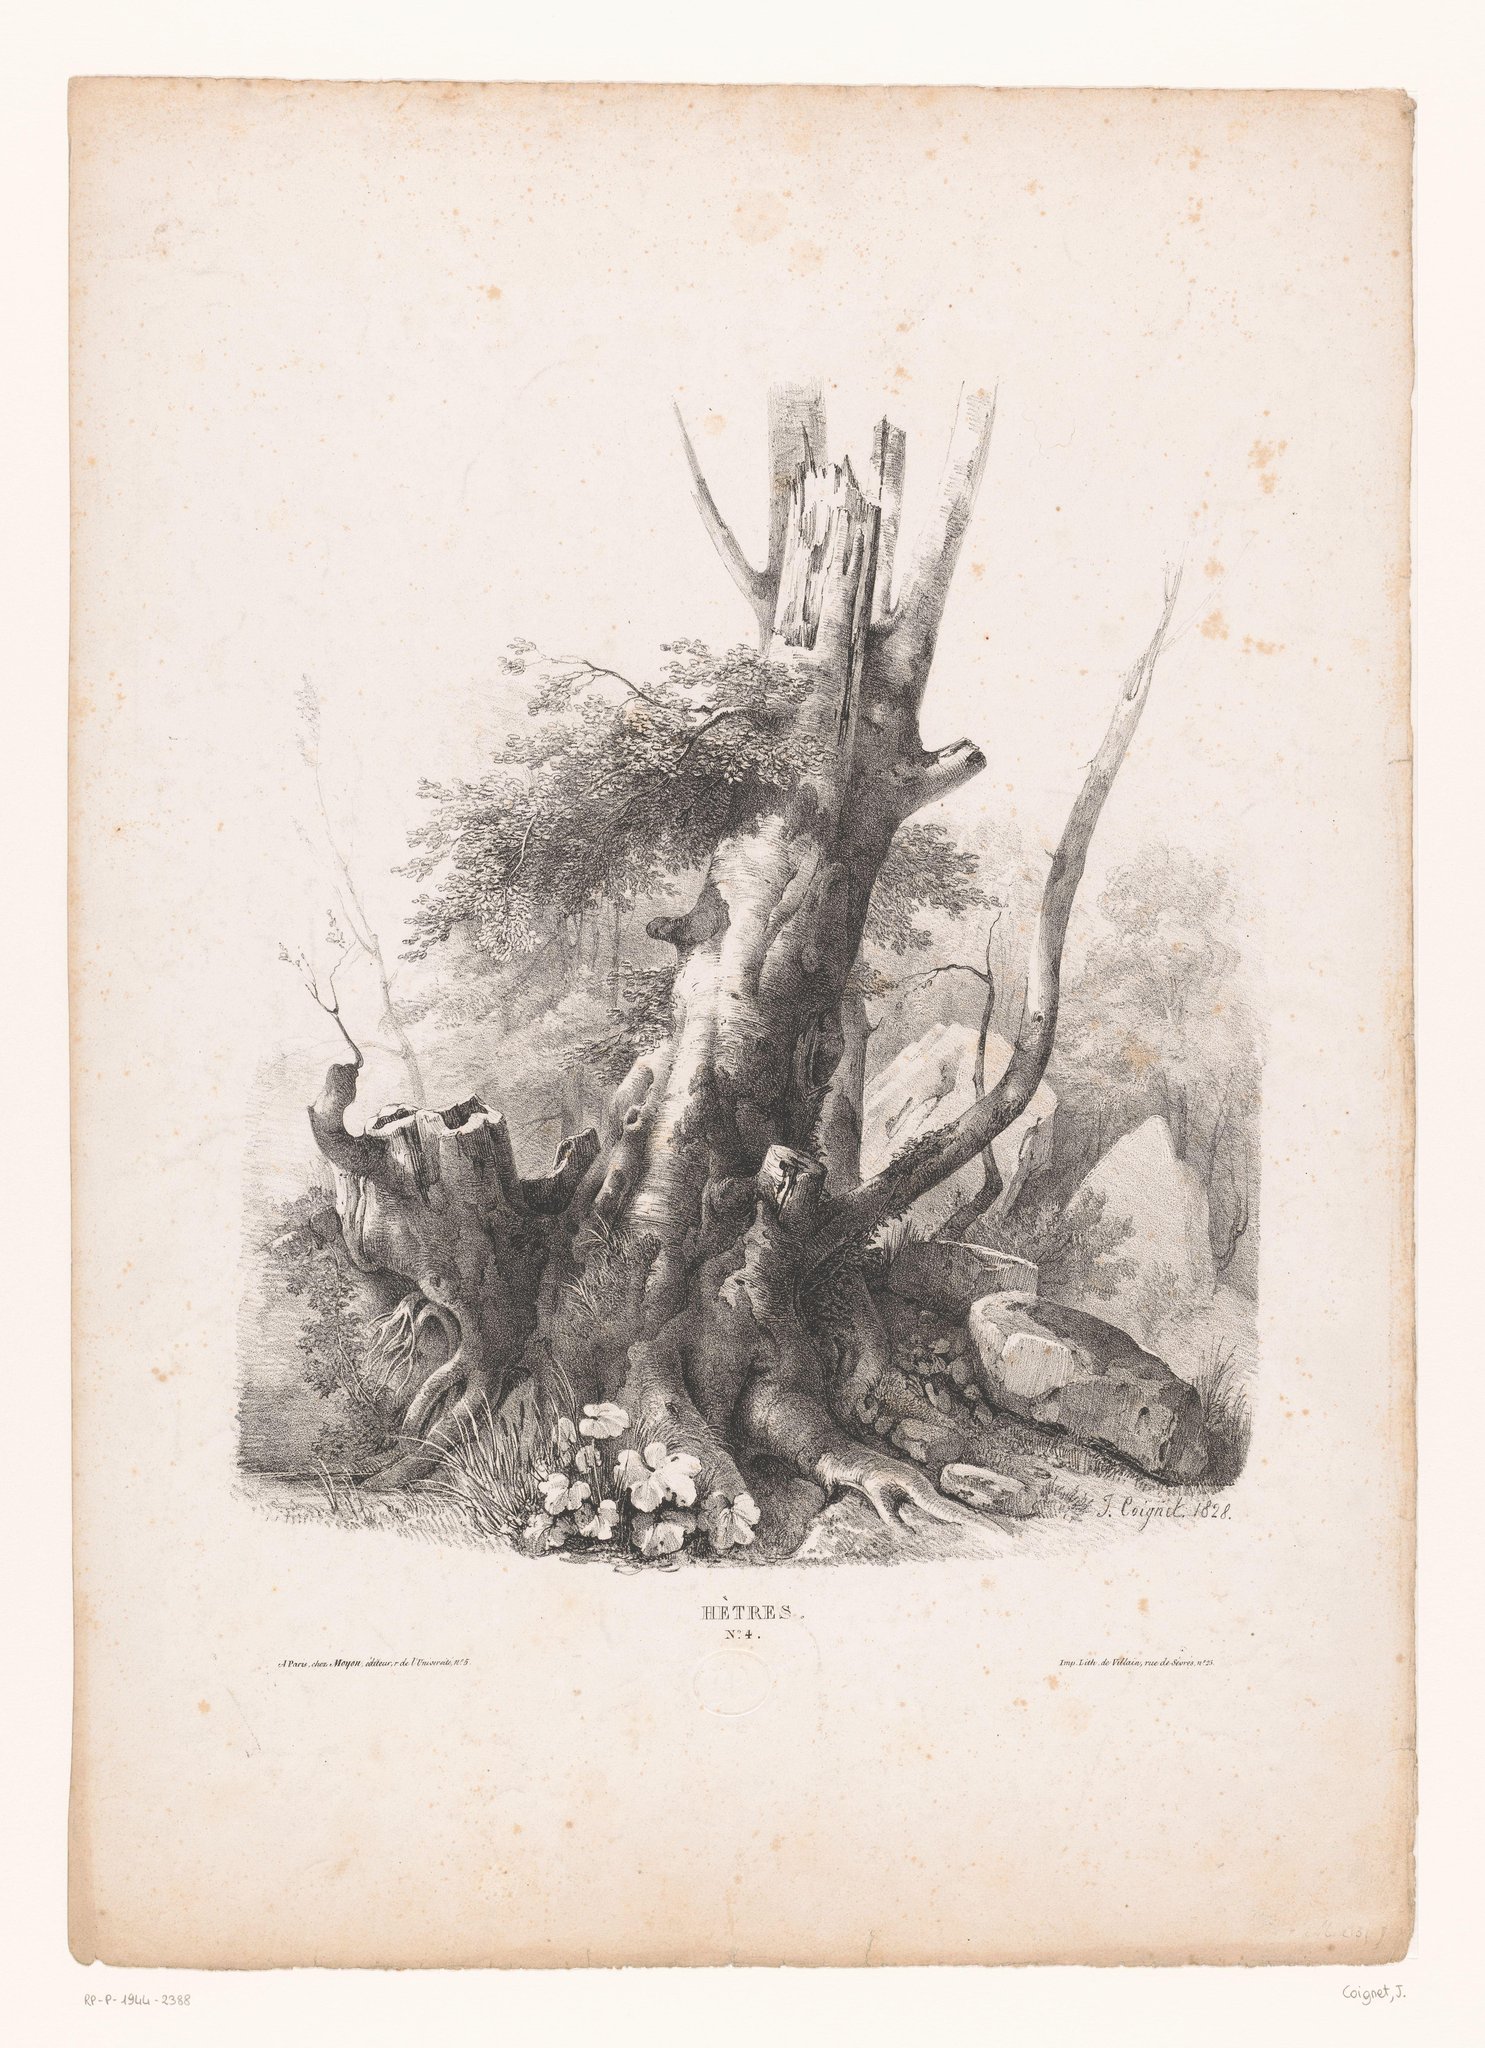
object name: print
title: Hètres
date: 1828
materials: paper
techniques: lithograph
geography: paris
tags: landscapes, trees: beech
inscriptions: collector's mark: Lugt 2228, inscription: ‘M. 03’, check stamp: Lugt 4590